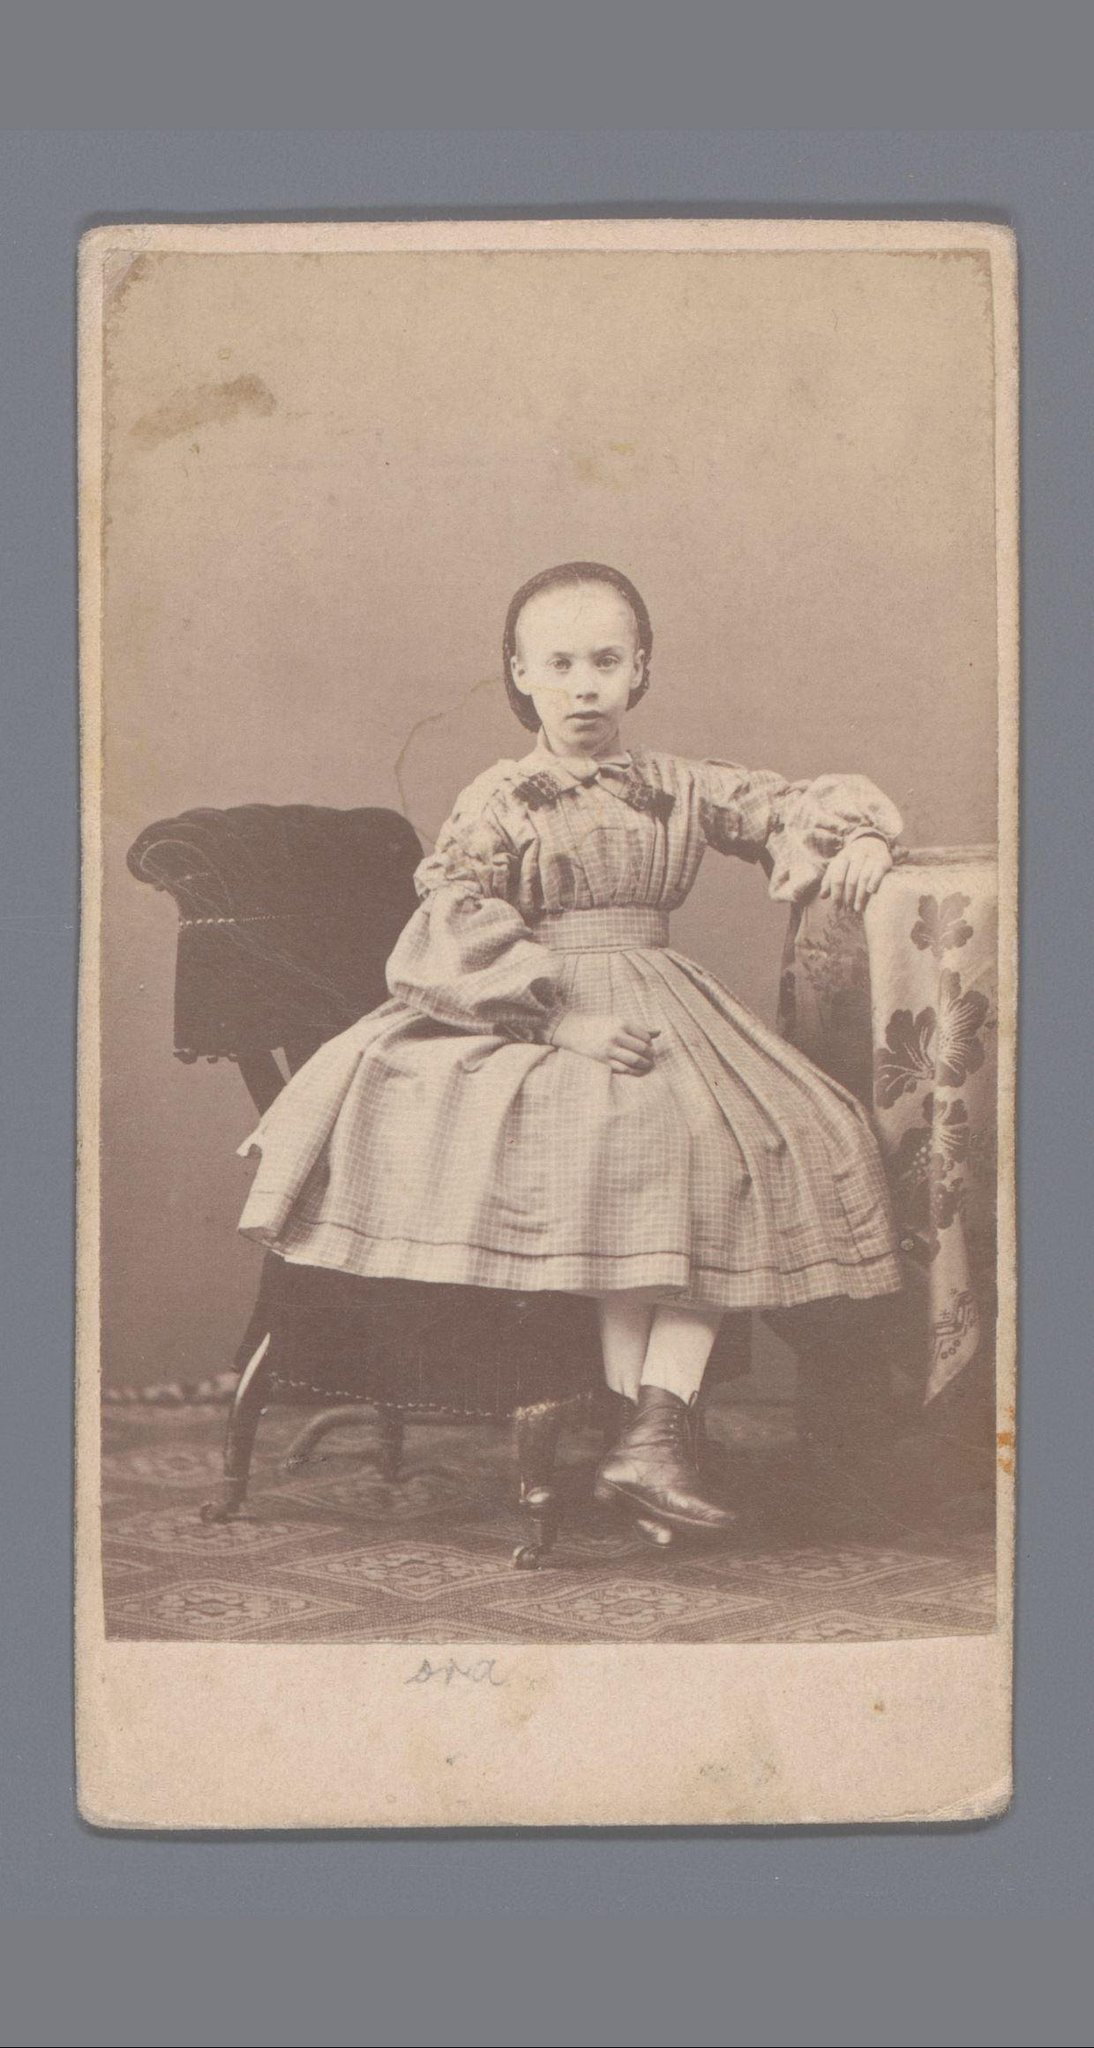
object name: carte de visite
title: Portret van een onbekend meisje op een stoel, aangeduid als Helena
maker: lindman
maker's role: fotograaf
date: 1863-1866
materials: cardboard, paper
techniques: albumen print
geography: stockholm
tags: sitting figure - aa - female human figure, girl (child between toddler and youth), anonymous historical person portrayed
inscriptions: inscription: ‘Helena’, inscription: ‘FOTOGRAFISK ATELIER/ LINDMAN/ Wahrendorffsgatan No. 8/ vid. Berzelii park.’